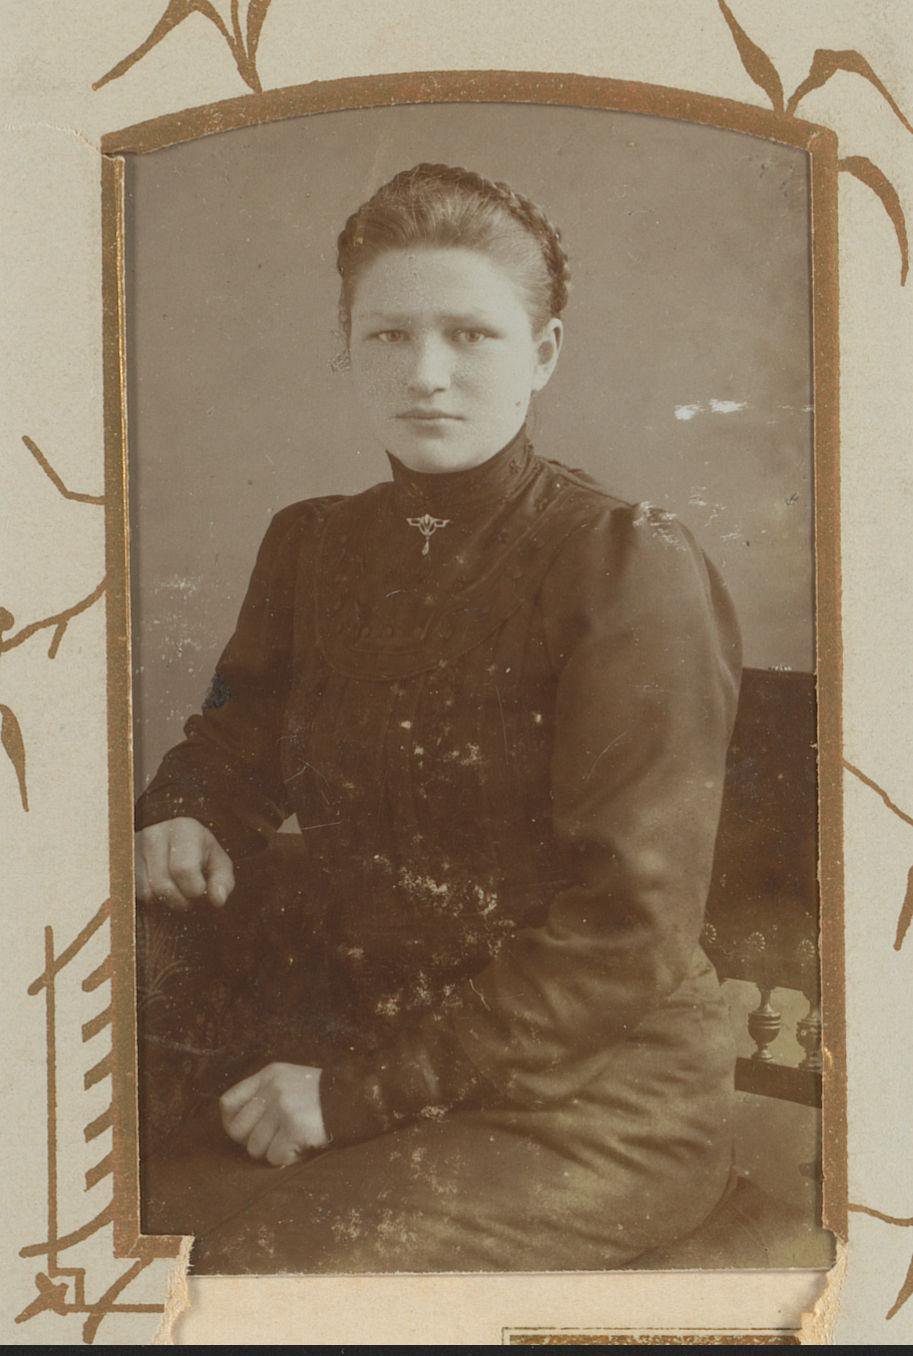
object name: carte de visite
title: Portret van een jonge vrouw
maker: stolley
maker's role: fotograaf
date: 1860-1900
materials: cardboard, photographic support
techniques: collodion silver print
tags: adolescent, young woman, maiden, historical persons